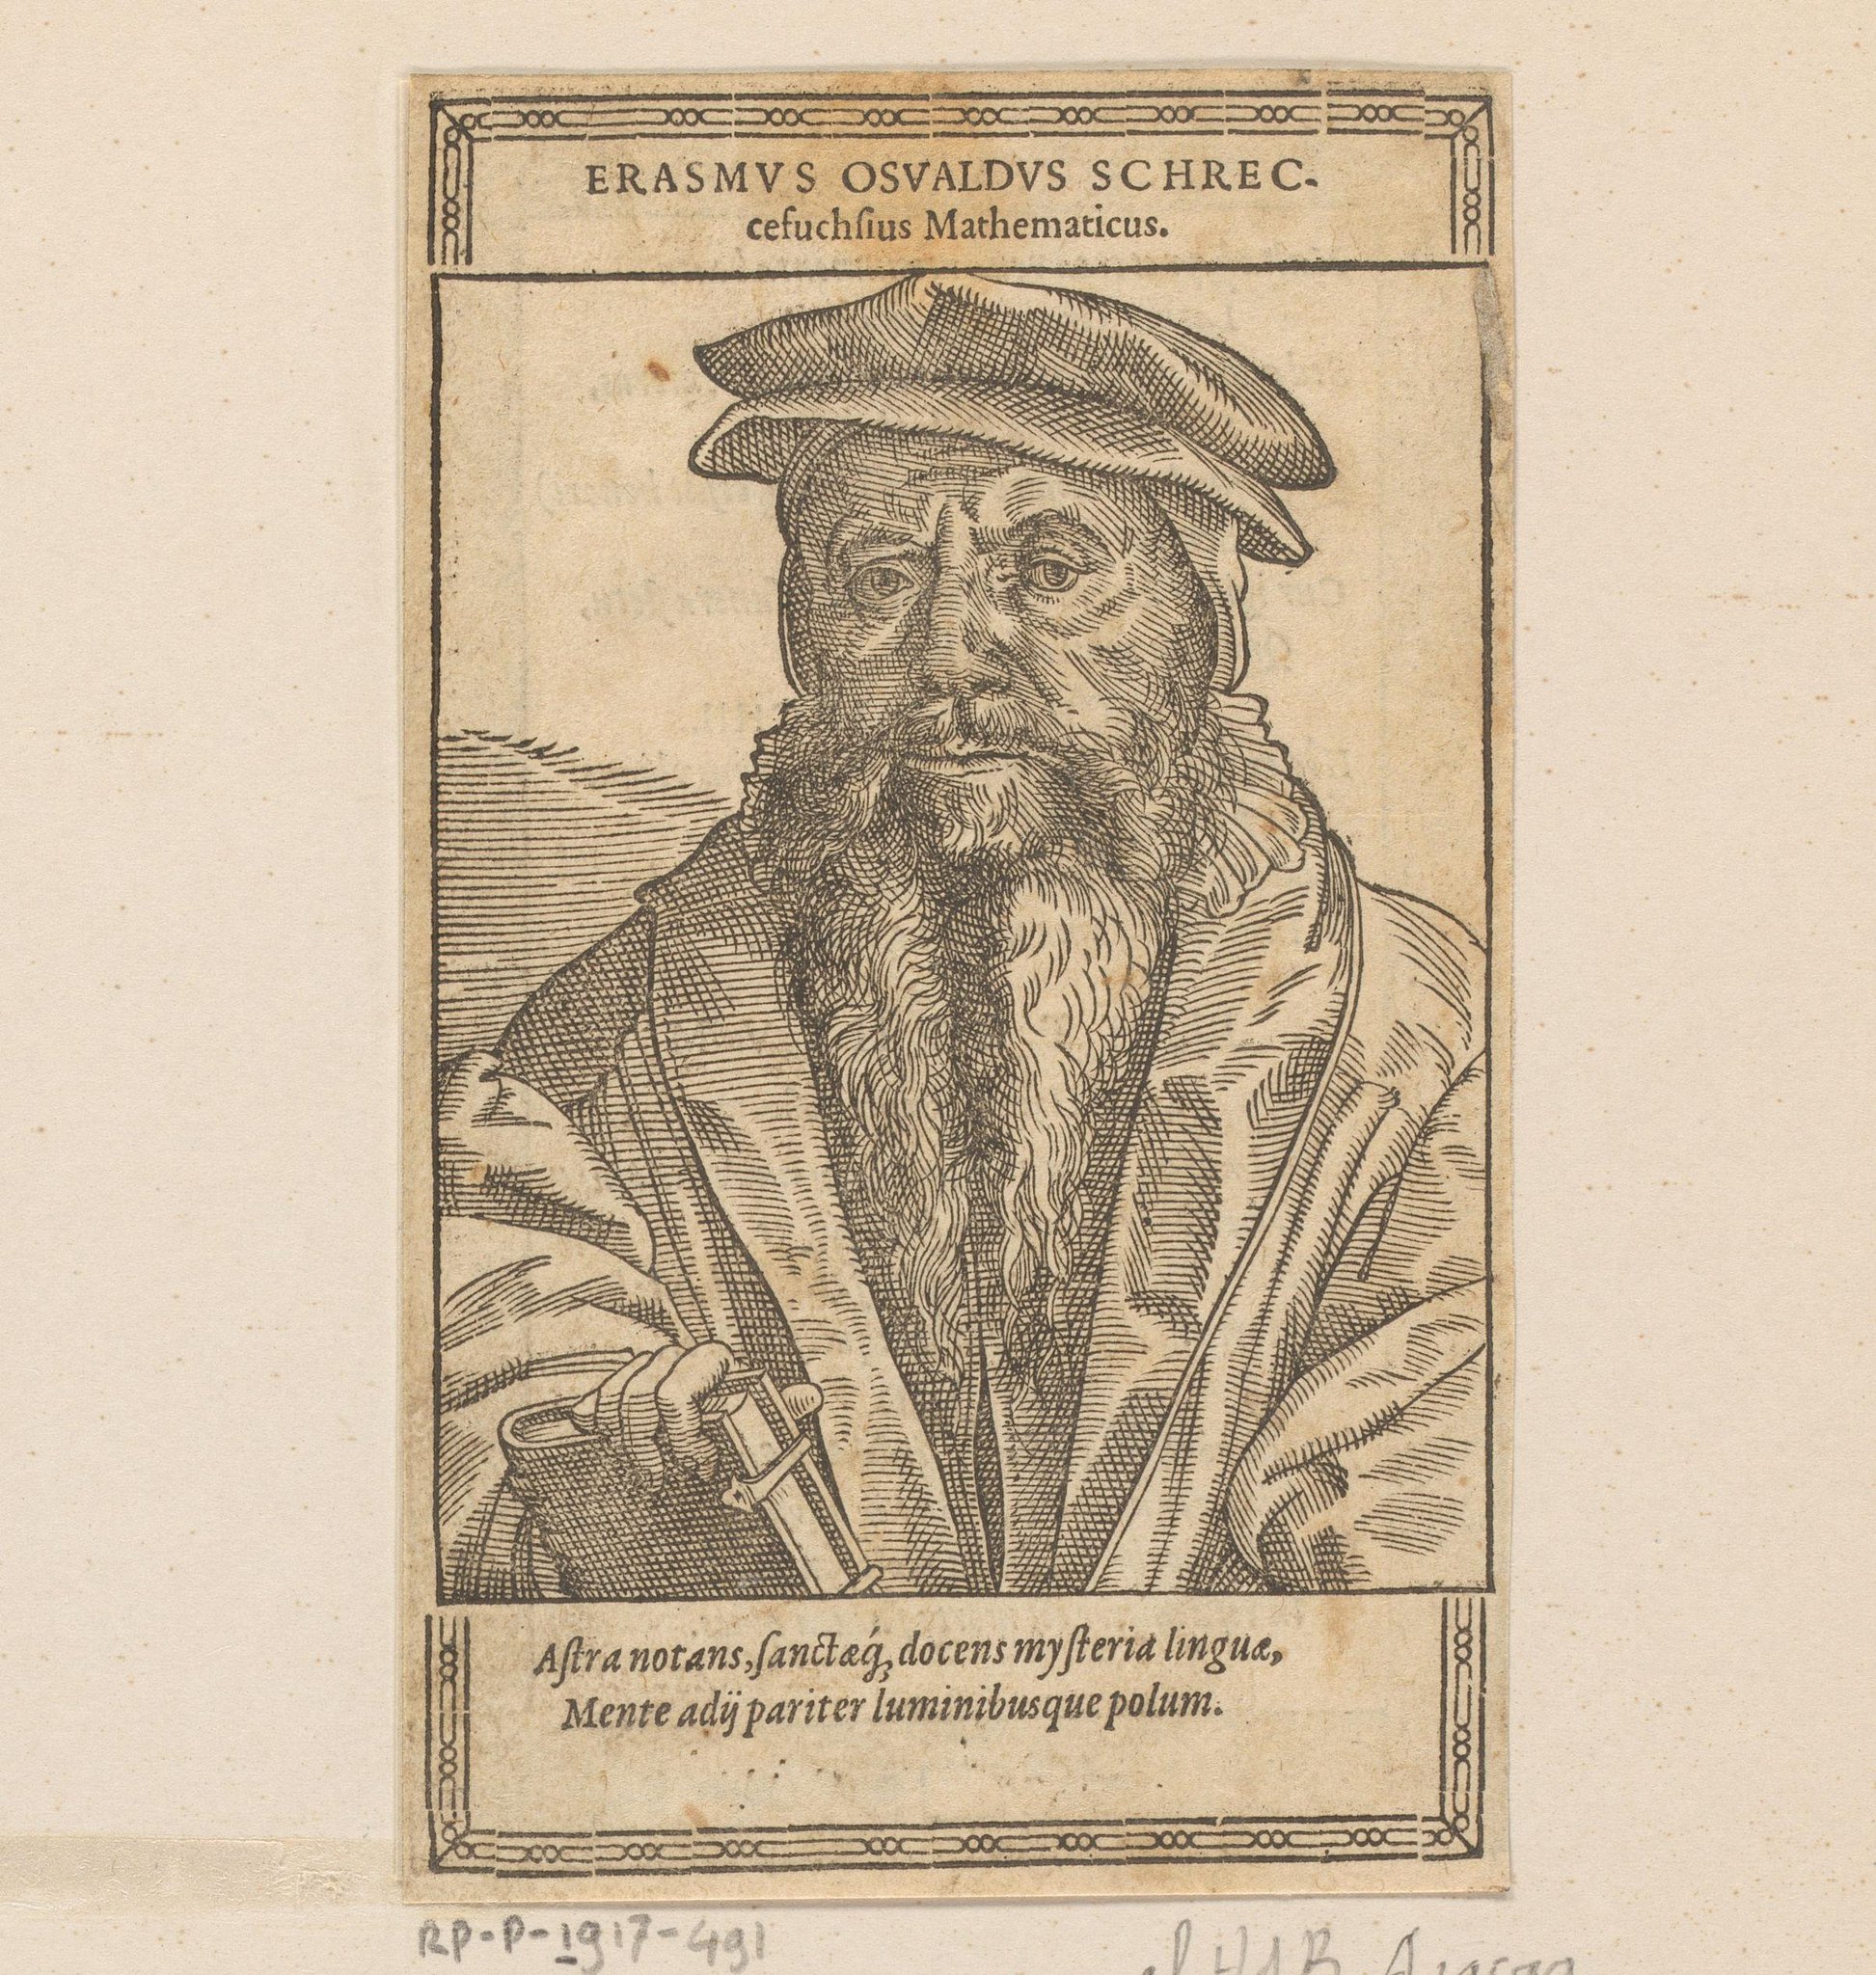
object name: print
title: Portret van Erasmus Oswald Schreckenfuchs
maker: bernhard jobin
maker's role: printer, publisher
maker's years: 1545-1593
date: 1587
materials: paper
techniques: letterpress printing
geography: straatsburg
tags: historical persons, mathematics (+ portrait of scholar, scientist)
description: Prent uit: Reusner, Nikolaus. Icones sive imagines virorum literis illustrium (...). Straatsburg: Bernhard Jobin, 1587. Prent ook gebruikt in de editie van 1590 en mogelijk in latere edities.